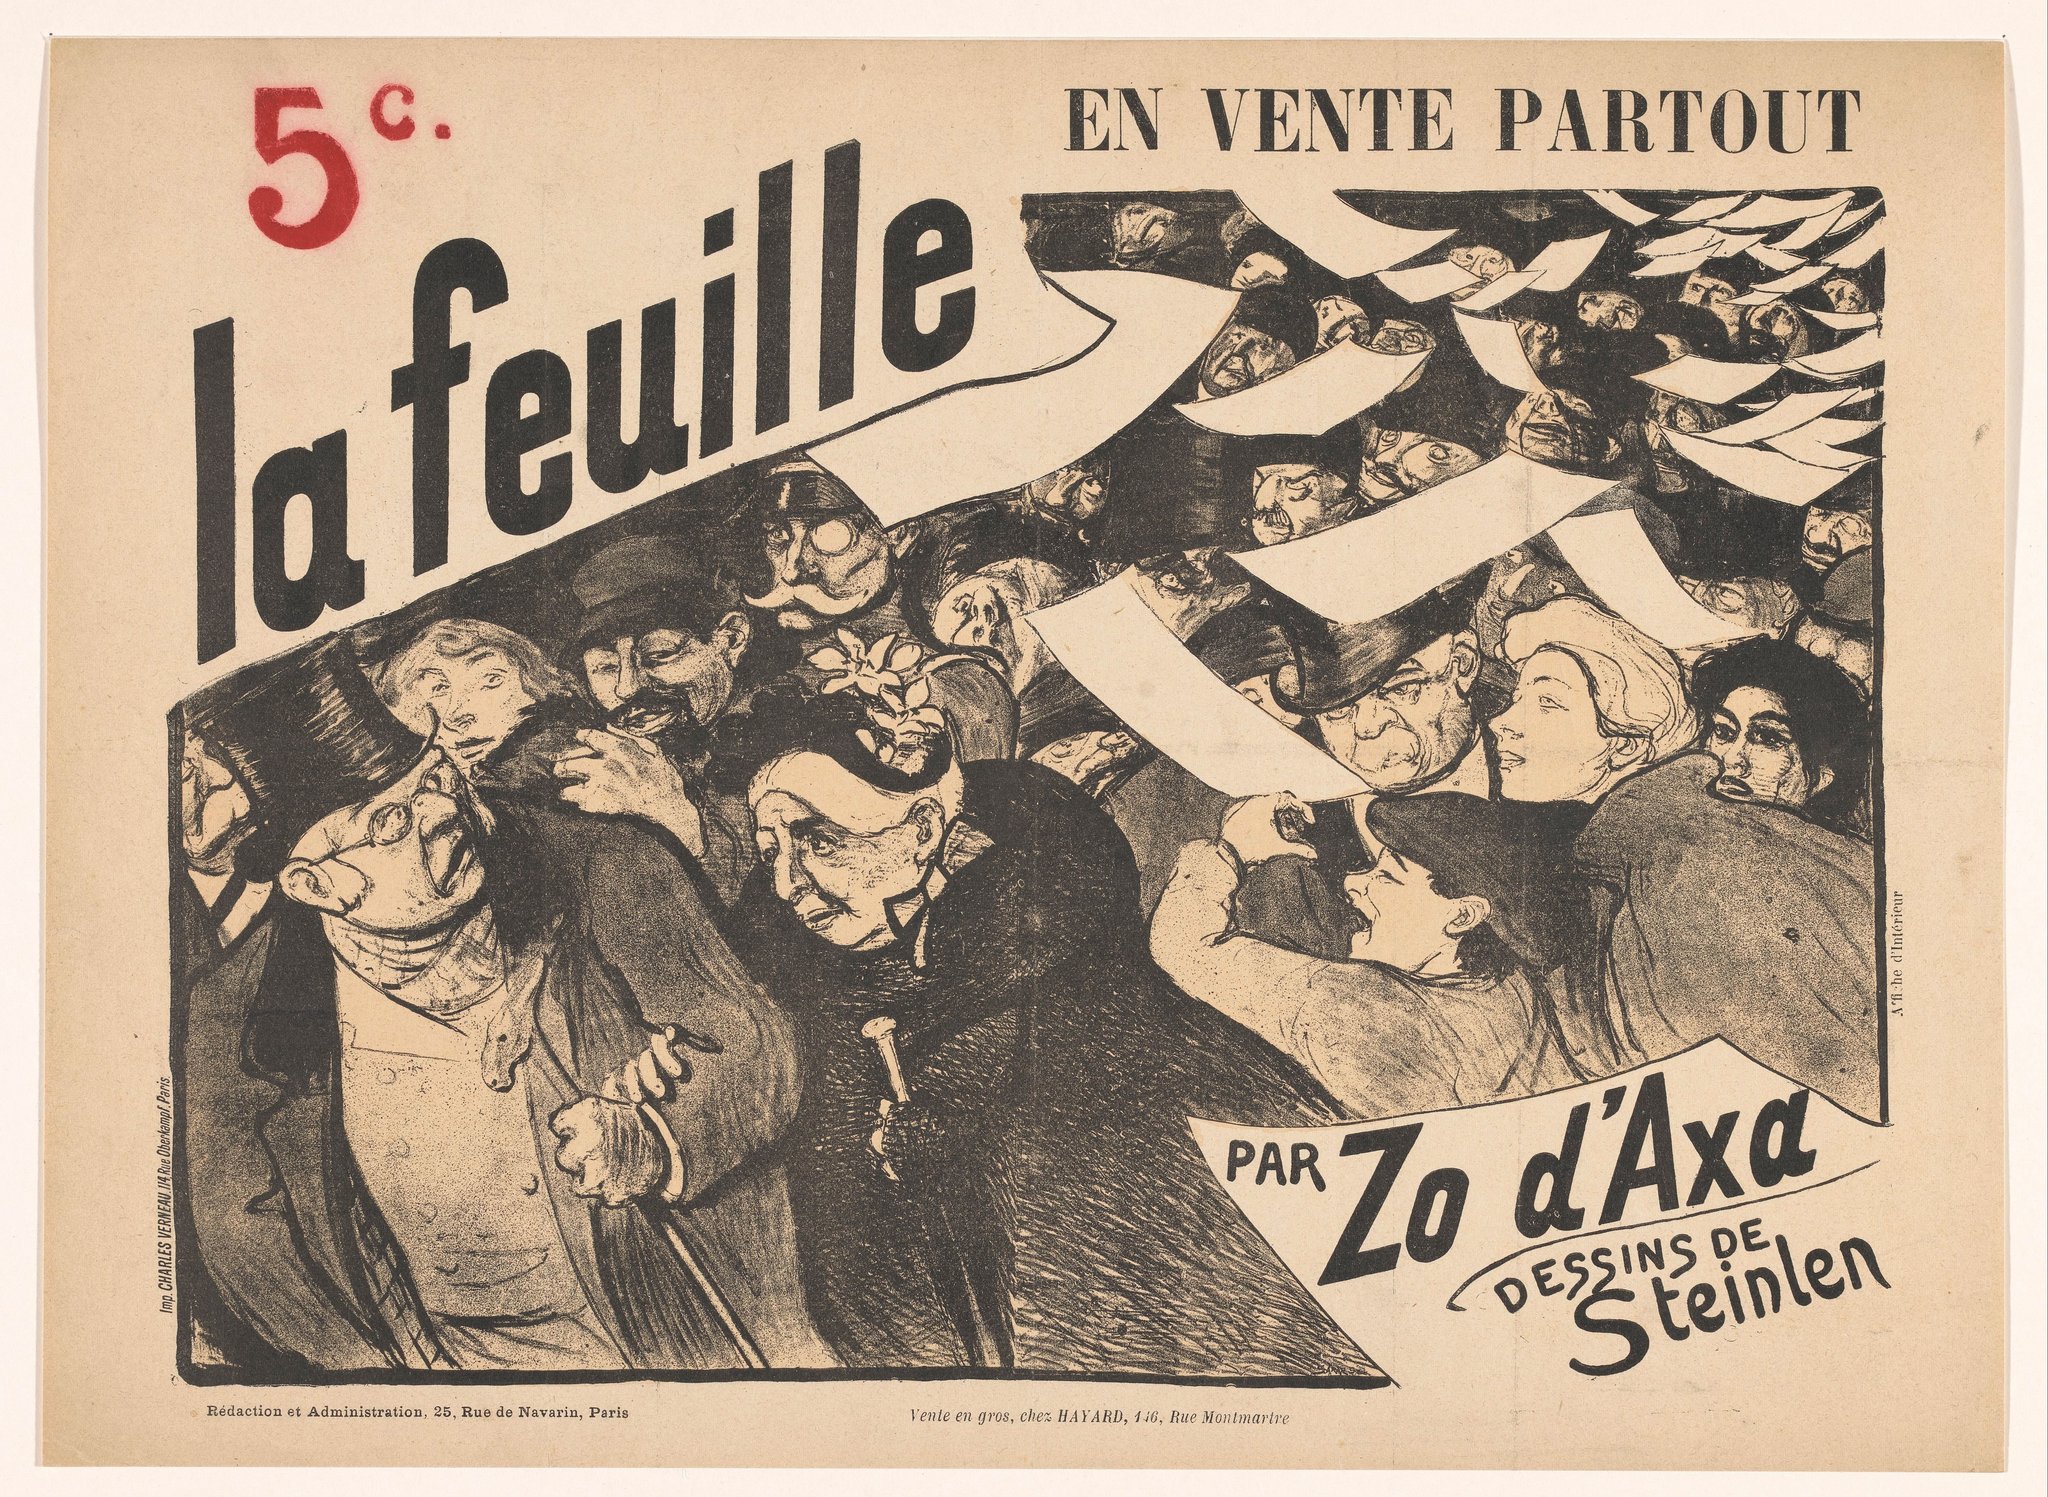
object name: print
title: Reclamebiljet voor La feuille door Zo d'Axa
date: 1897-1899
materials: paint, paper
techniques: brush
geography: paris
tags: newspaper, news-sheet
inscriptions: collector's mark: Lugt 2228, collector's mark: Lugt 4779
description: Reclamebiljet voor het tijdschrift 'La Feuille', verschenen tussen 1897-1899. De oprichter van het tijdschrift was Zo d'Axa, pseudoniem van Alphonse Gallaud de la Pérouse (1864-1930).